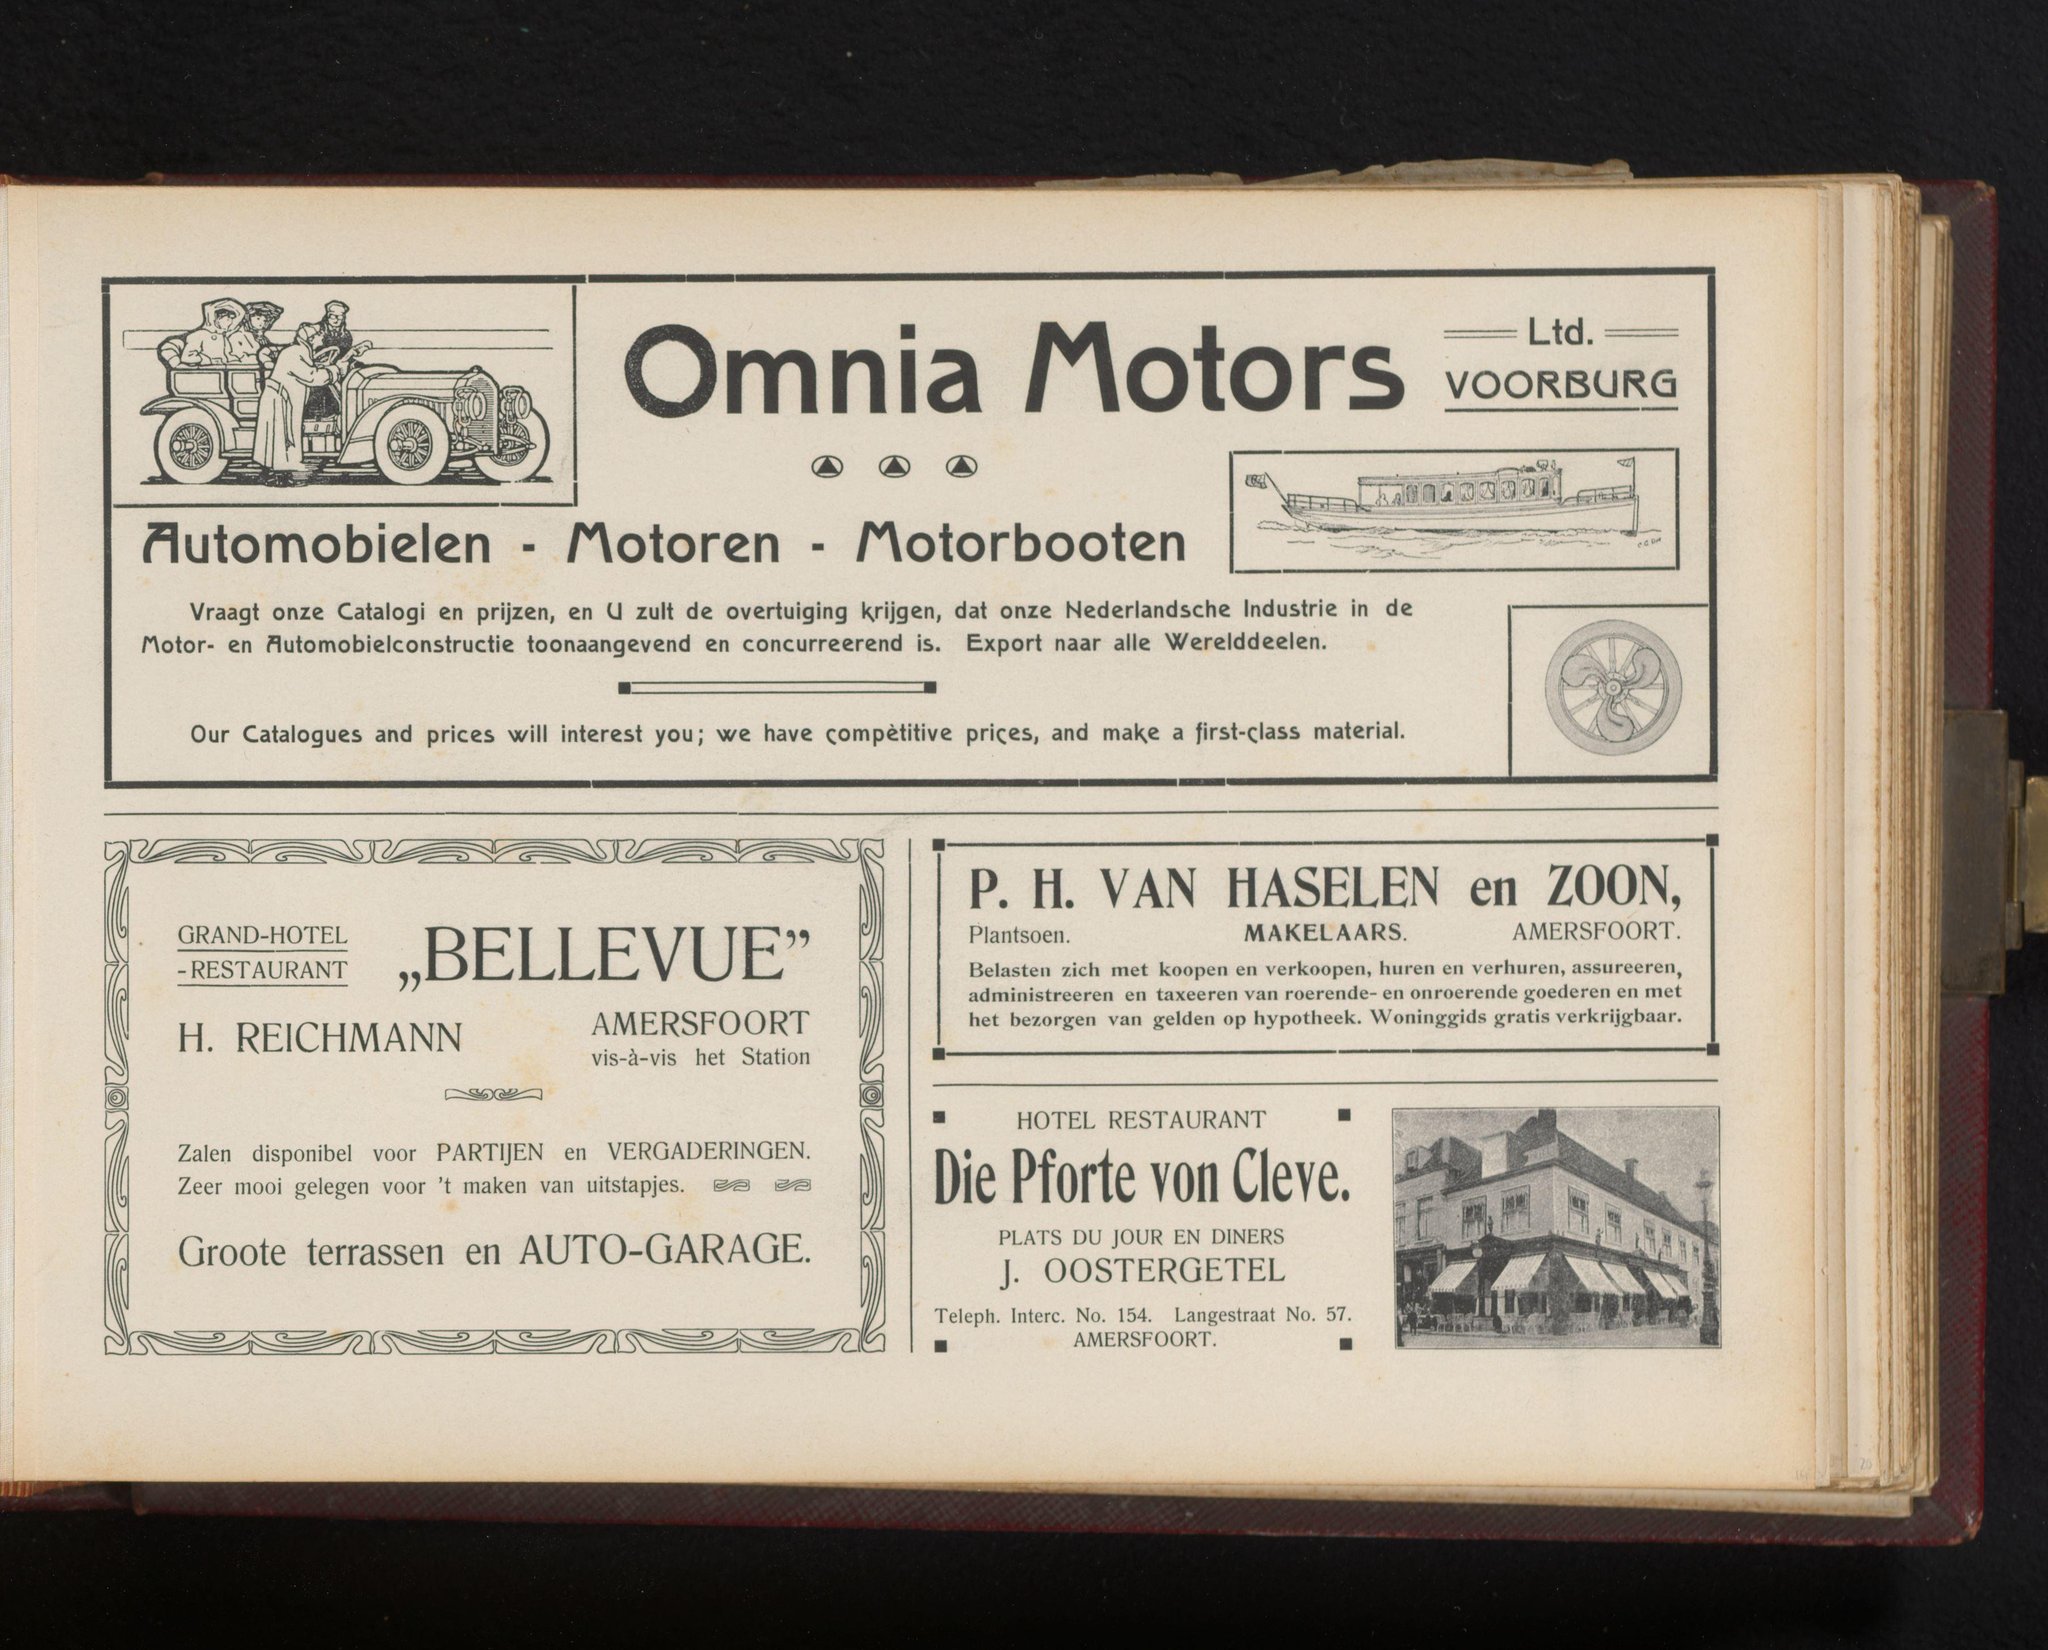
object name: photomechanical print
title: Advertenties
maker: Anonymous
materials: paper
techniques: printing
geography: netherlands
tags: advertising, restaurant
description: Advertenties voor onder andere Omnia Motors, Grand-Hotel Restaurant Bellevue, P.H. van Haselen en Zoon makelaars en Hotel Restaurant Die Pforte von Cleve. Deze pagina maakt deel uit van een album.